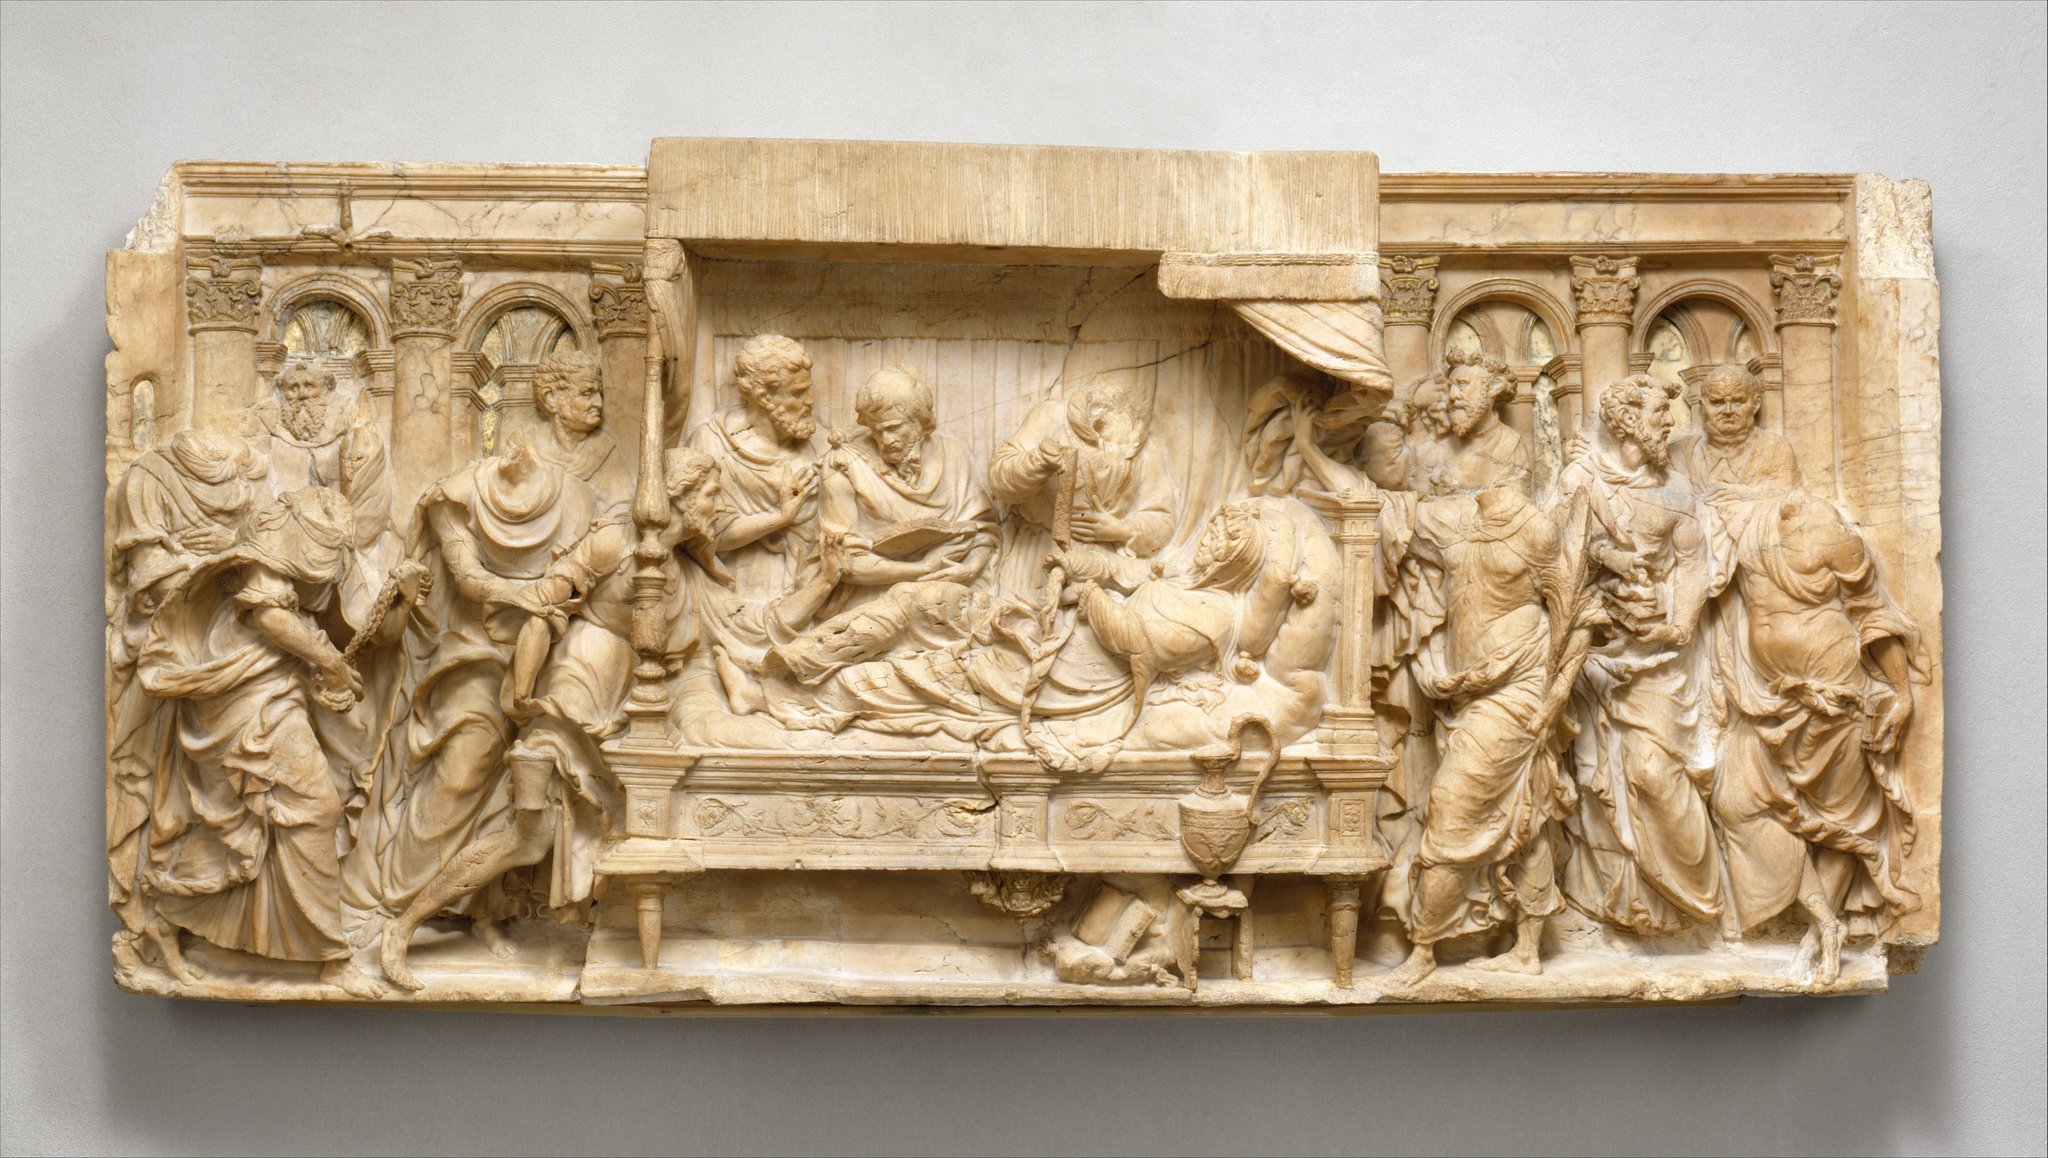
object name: high relief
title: The Dormition of the Virgin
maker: jacques juliot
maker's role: maker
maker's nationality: french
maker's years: 1540-1552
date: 1540-1550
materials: alabaster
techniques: gilding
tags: apostles,saint john the evangelist,saint peter,virgin mary,beds